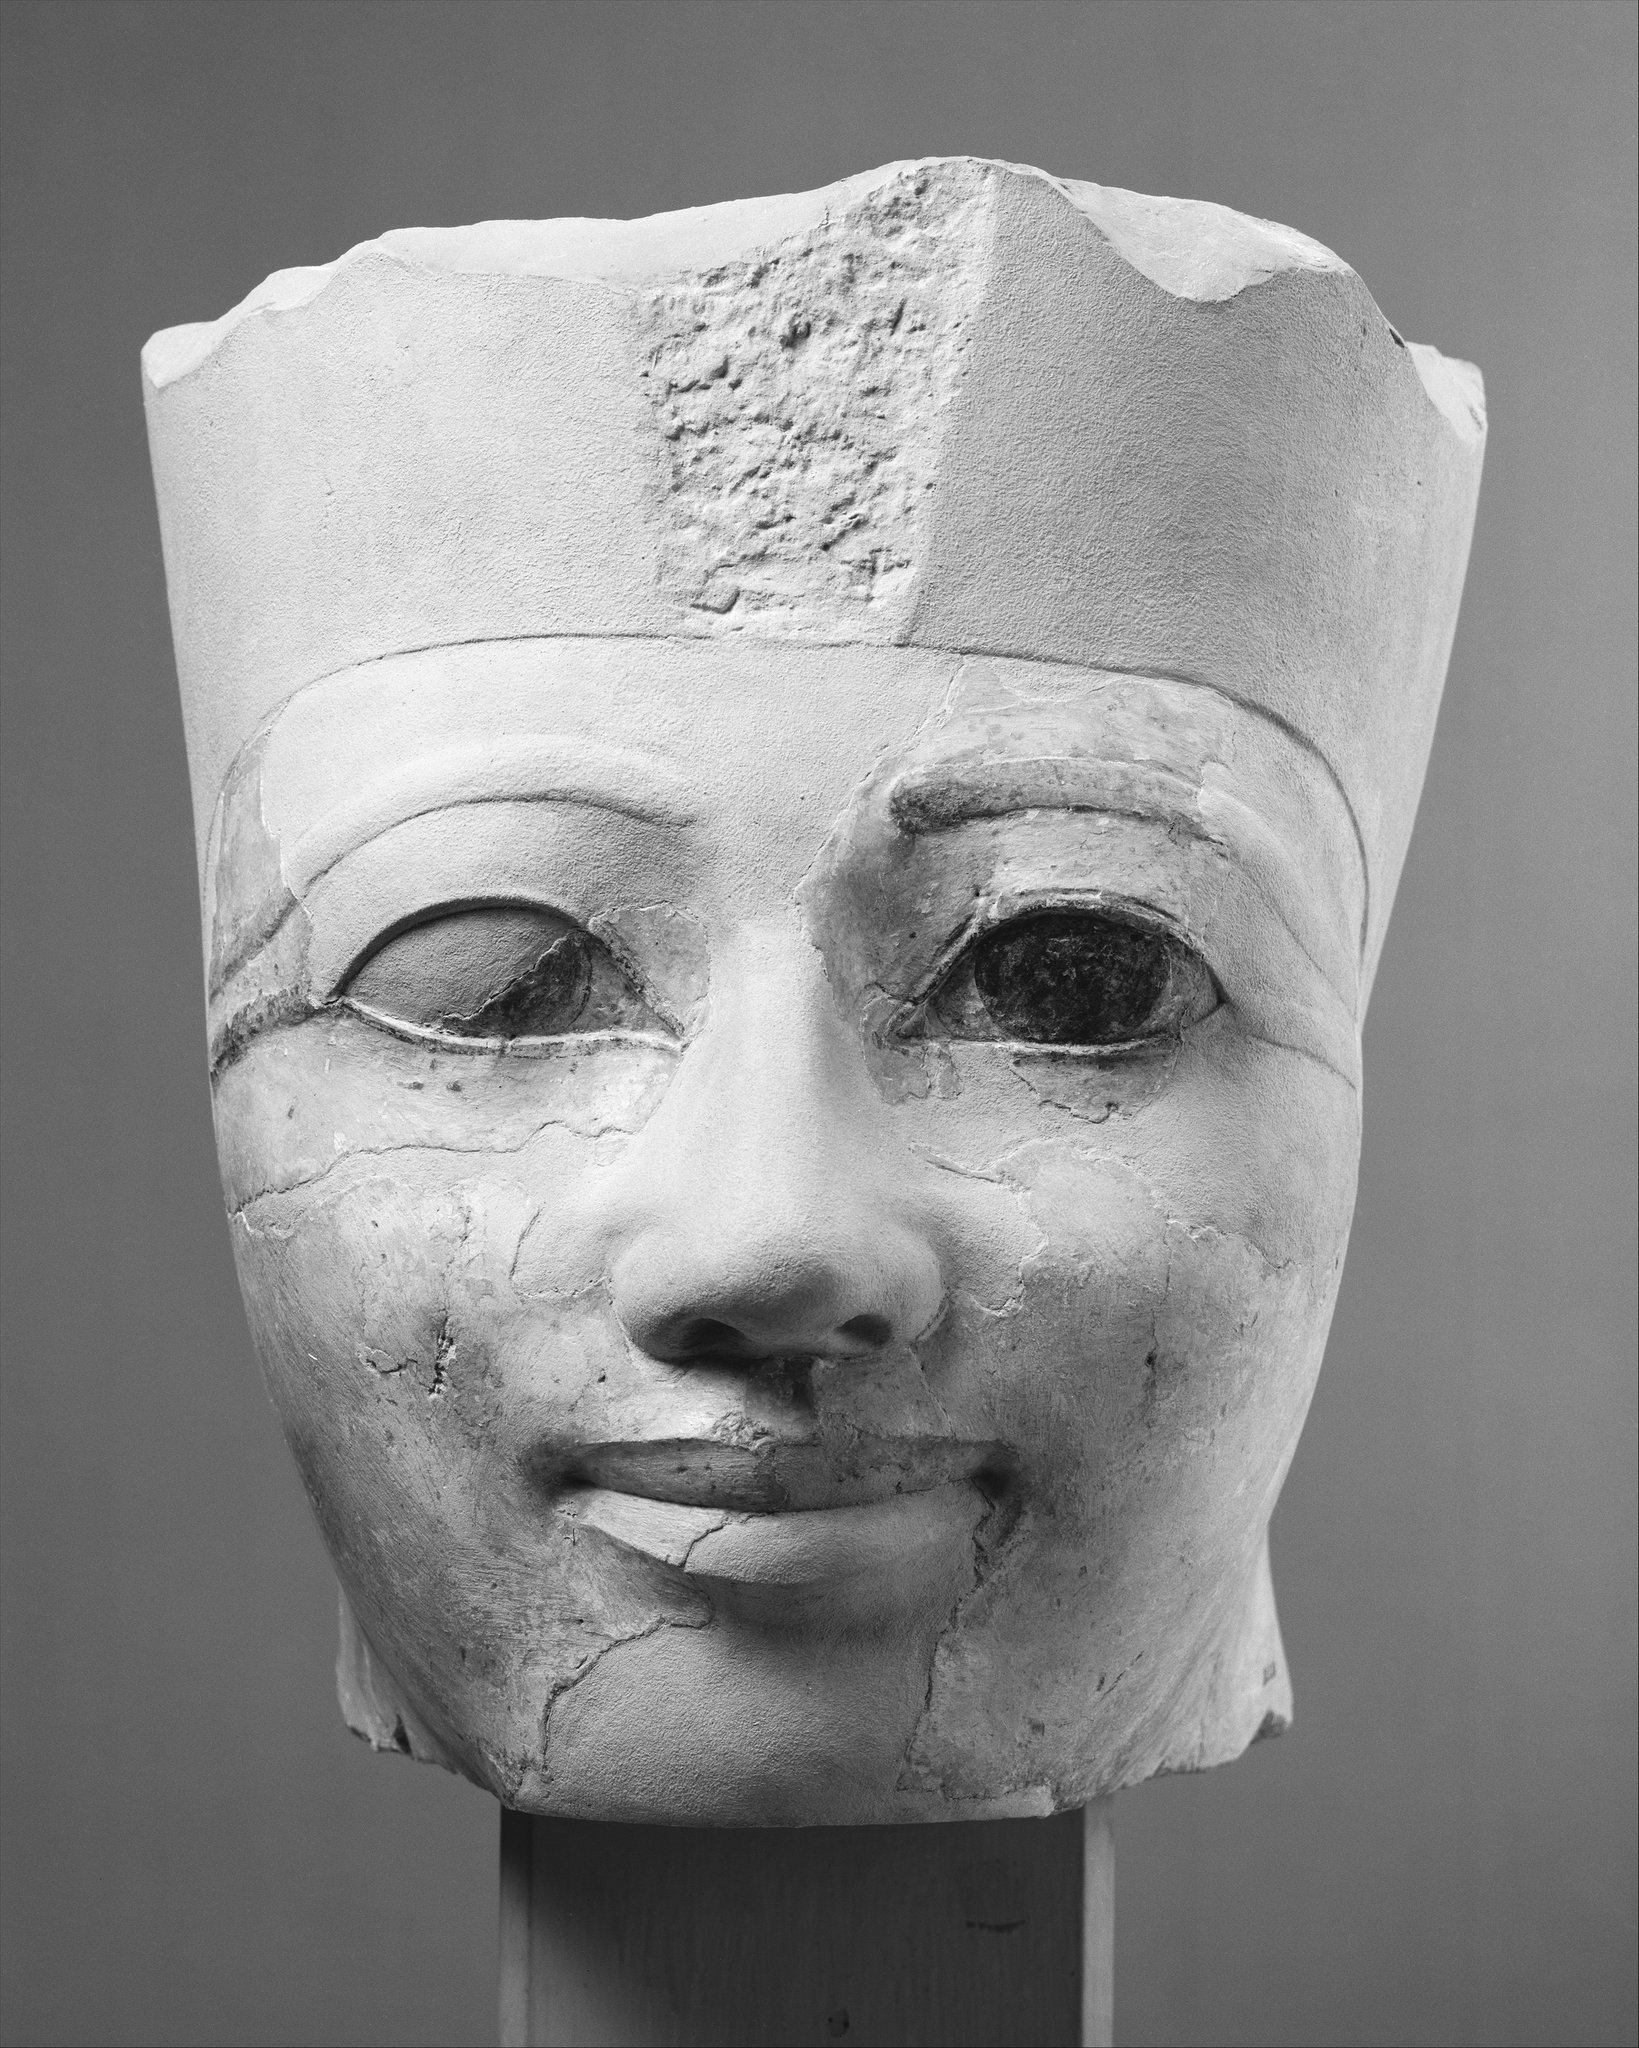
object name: head, hatshepsut, sanctuary, white crown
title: Head of an Osiride Statue of Hatshepsut Originally in the Temple Sanctuary SE Corner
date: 1479-1458 BCE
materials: limestone, paint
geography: egypt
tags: heads